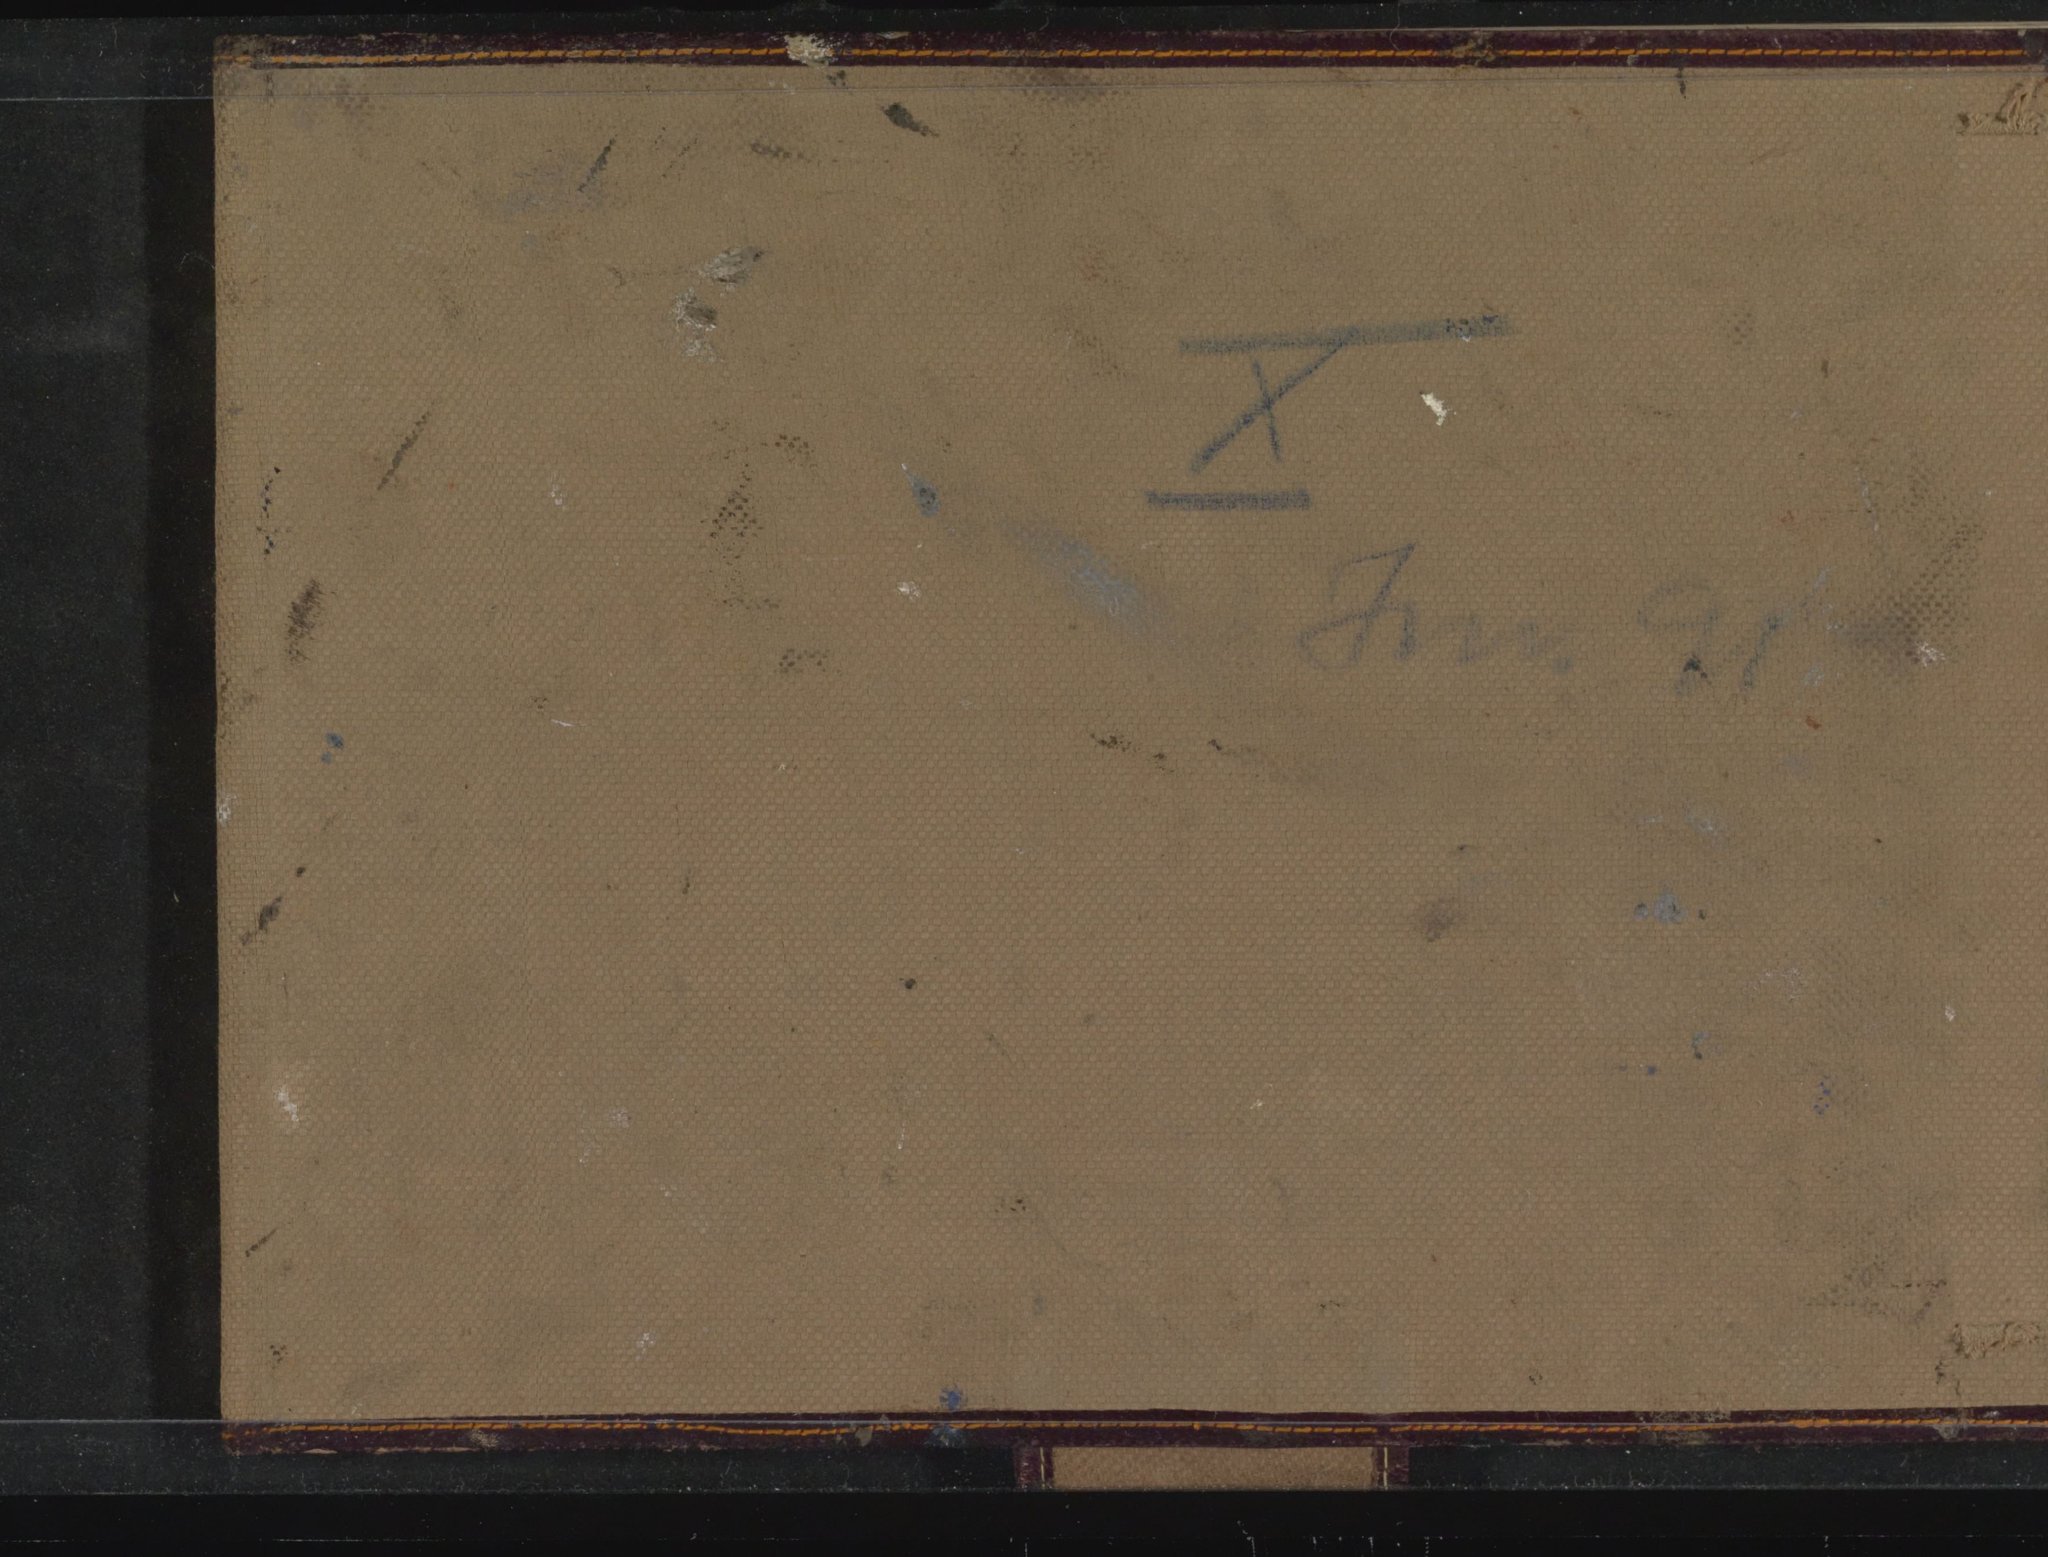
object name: sketchbook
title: Schetsboek X met 43 bladen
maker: isaac israels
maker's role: draughtsman, painter, print maker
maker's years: 1865-1934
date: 1890-1920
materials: cardboard, chalk, charcoal, leather, linen, paper, pencil, watercolor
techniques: brush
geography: the hague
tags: billiards, ass, donkey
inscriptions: collector's mark: Lugt 2228, retailer's mark: ‘W.M. Stam / Schilder- en / Teekenbehoeften. / Papestraat 15 / Den Haag’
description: Bladen 4(V), 5(R), 8(V), 9(V) t/m 11(R), 14(V) t/m 17(V), 20(R), 21(V), 22(R) t/m 24(R), 26(V), 27(R), 30(V), 31(R), 34(V) t/m 39(R), 40(V), 41(R), 42(V), 43(R) en beide schutblad zijn blanco en daarom niet beschreven.